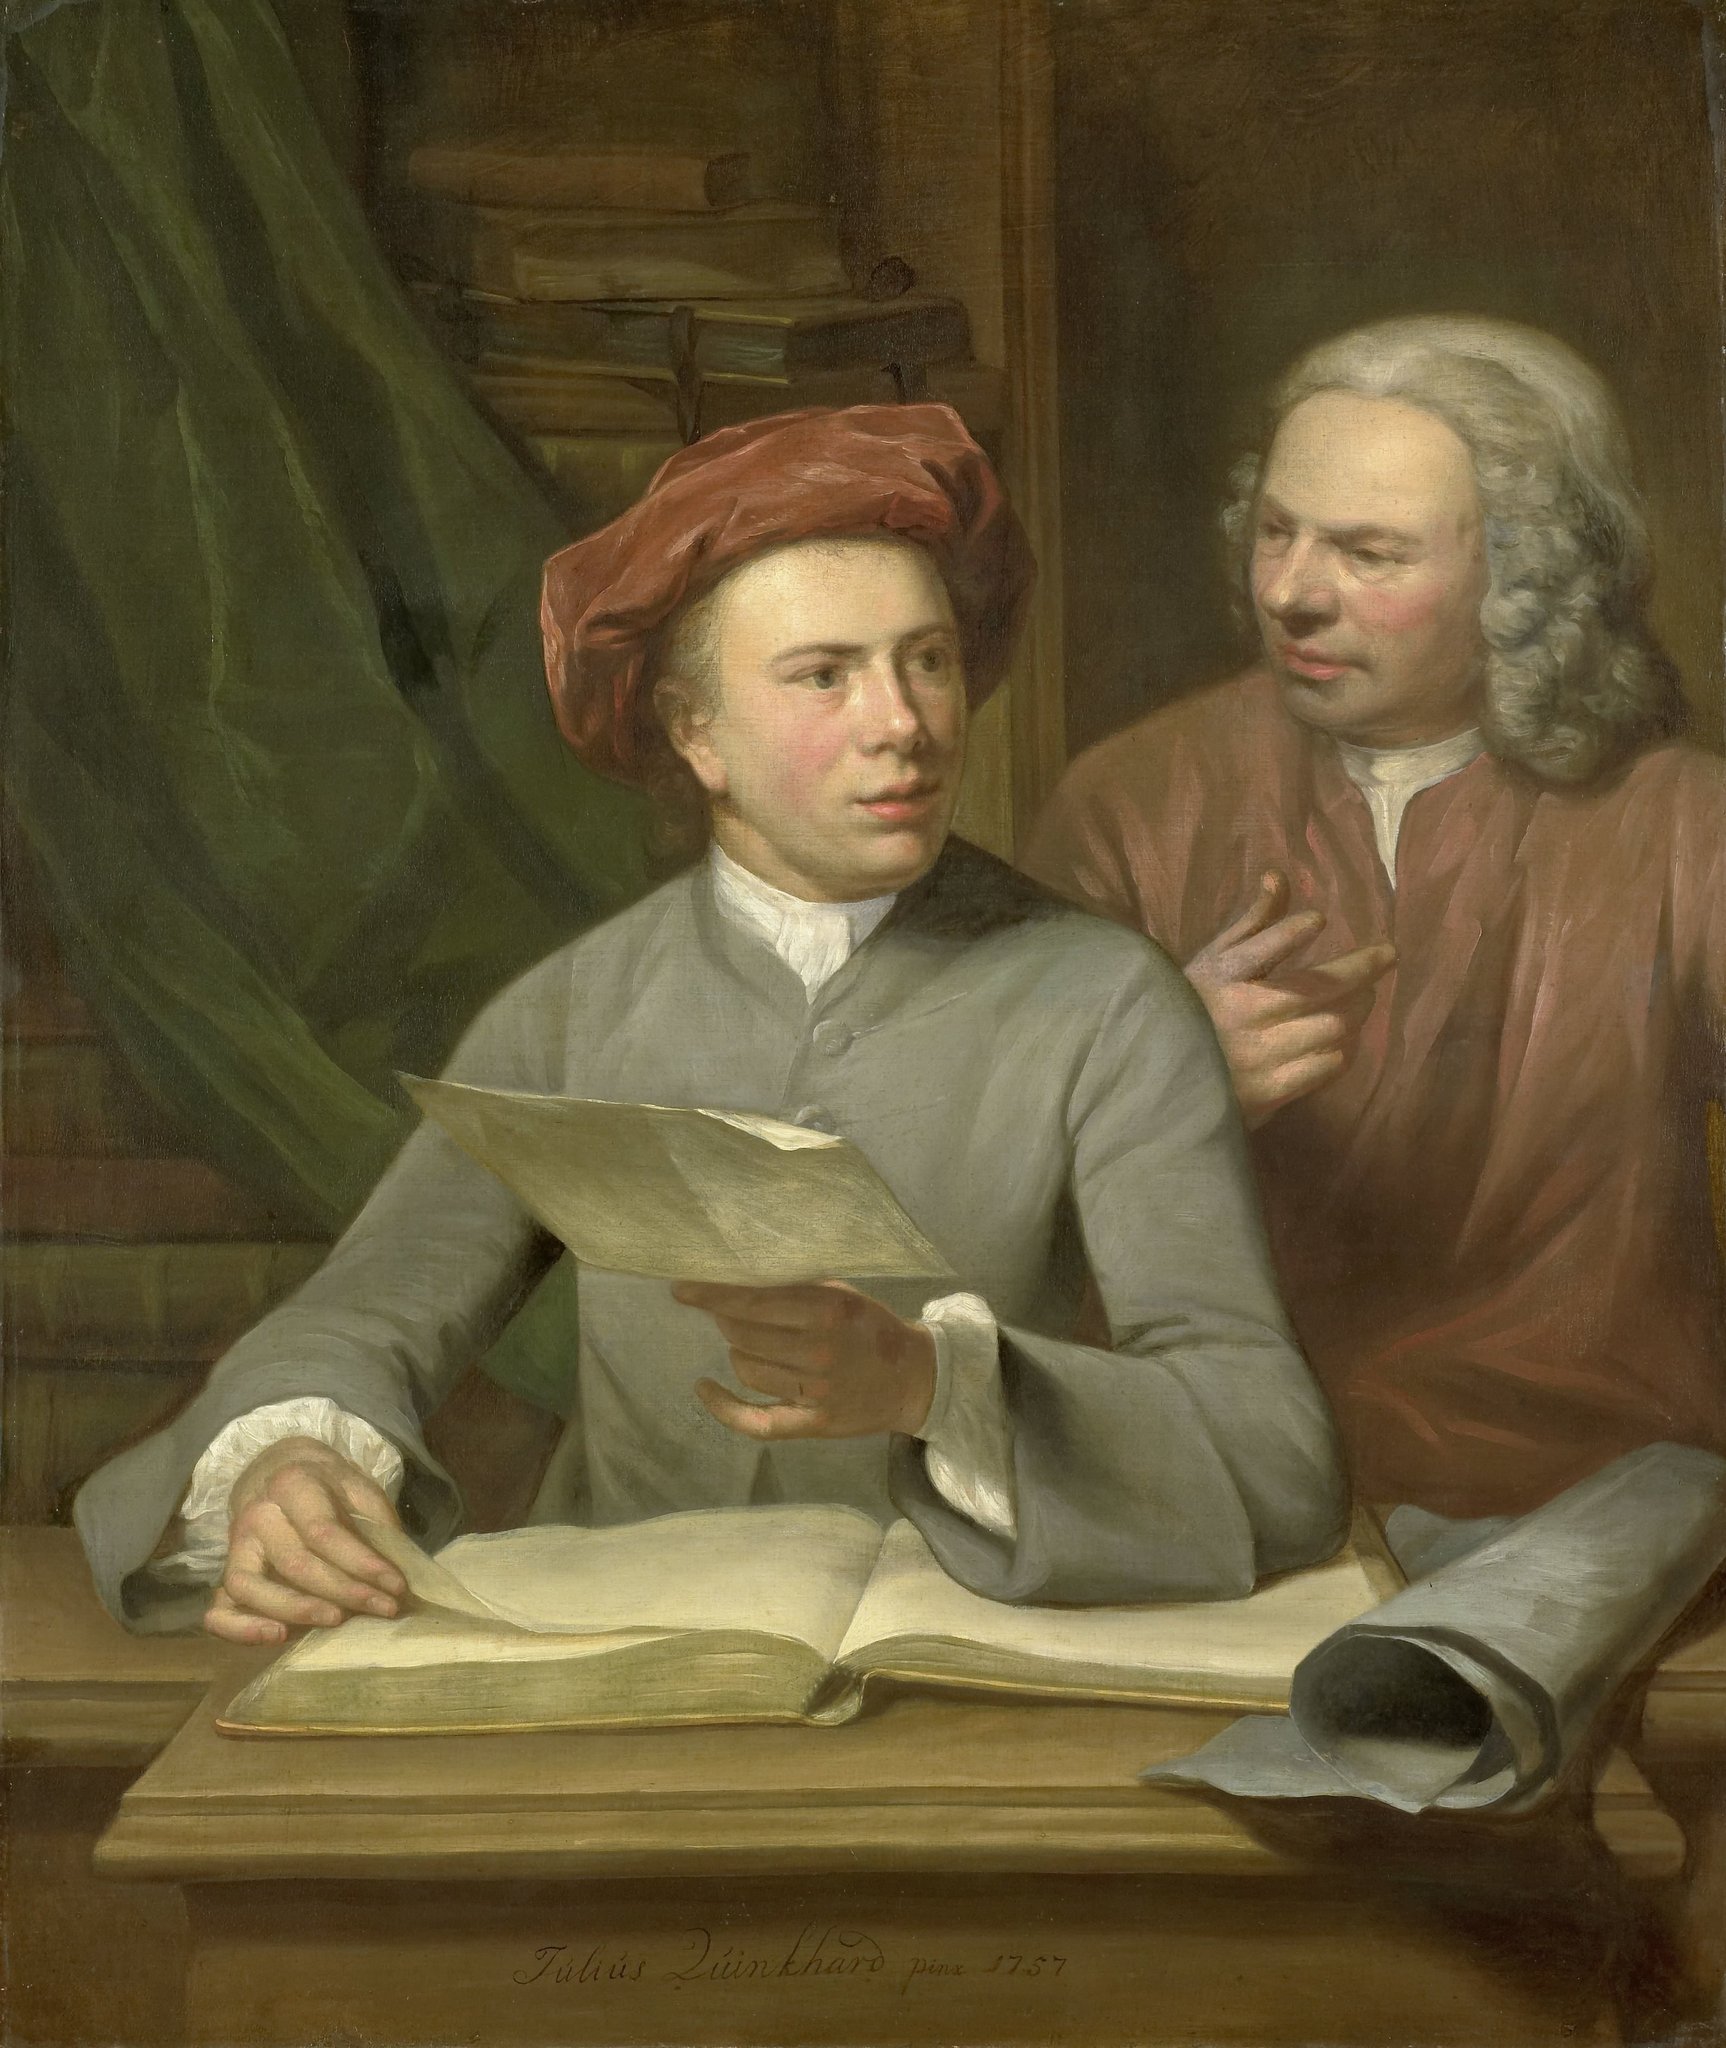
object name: painting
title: Self Portrait. Standing beside the Artist is his Father and Teacher Jan Maurits Quinkhard (1688-1772)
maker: julius henricus quinkhard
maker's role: draughtsman, painter, print maker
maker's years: 1734-1795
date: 1757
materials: canvas, oil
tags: amsterdam, draughtsman, jan maurits quinkhard, print maker, julius henricus quinkhard, historical persons, portrait, self-portrait of painter, portrait, self-portrait of artist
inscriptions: signature and date: ‘Julius Quinkhard pinx 1757’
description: Zelfportret van de schilder Julius Henricus Quinkhard (1734-1795), met achter hem staande zijn vader en leermeester Jan Maurits Quinkhard (1688-1772). Ten halven lijve, zittend aan een tafel, een boek doorbladerend. In de linkerhand een blad papier (een tekening?).